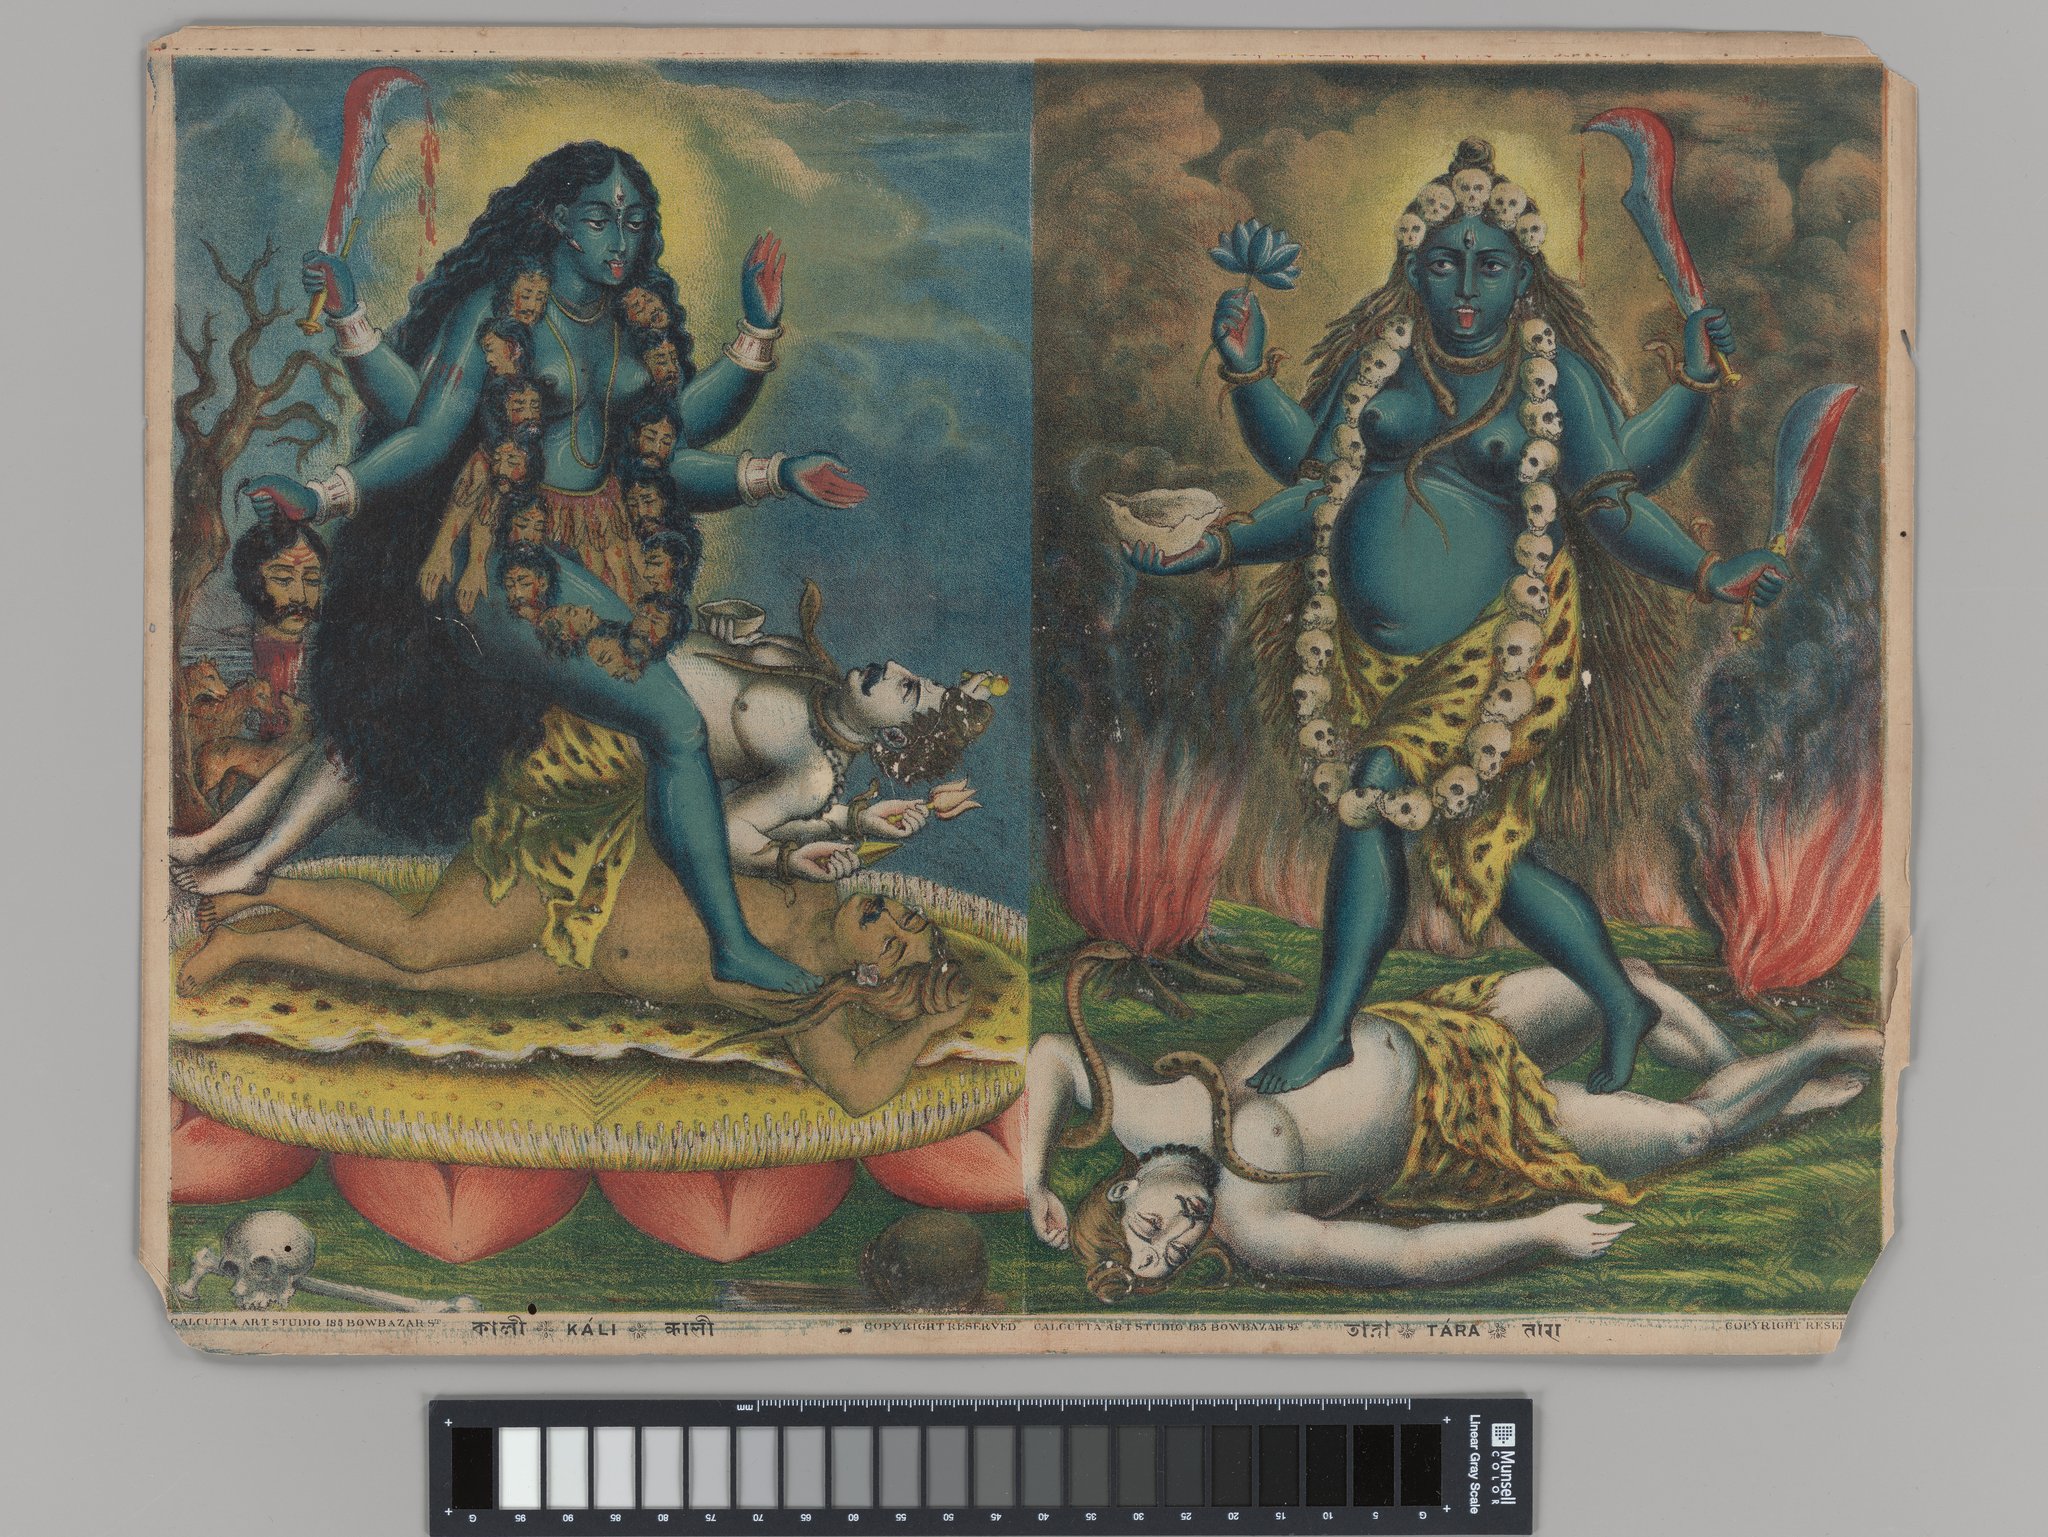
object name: print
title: Kali/Tara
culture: indian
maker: calcutta art studio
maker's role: artist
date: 1885-1890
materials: chromolithograph, paper